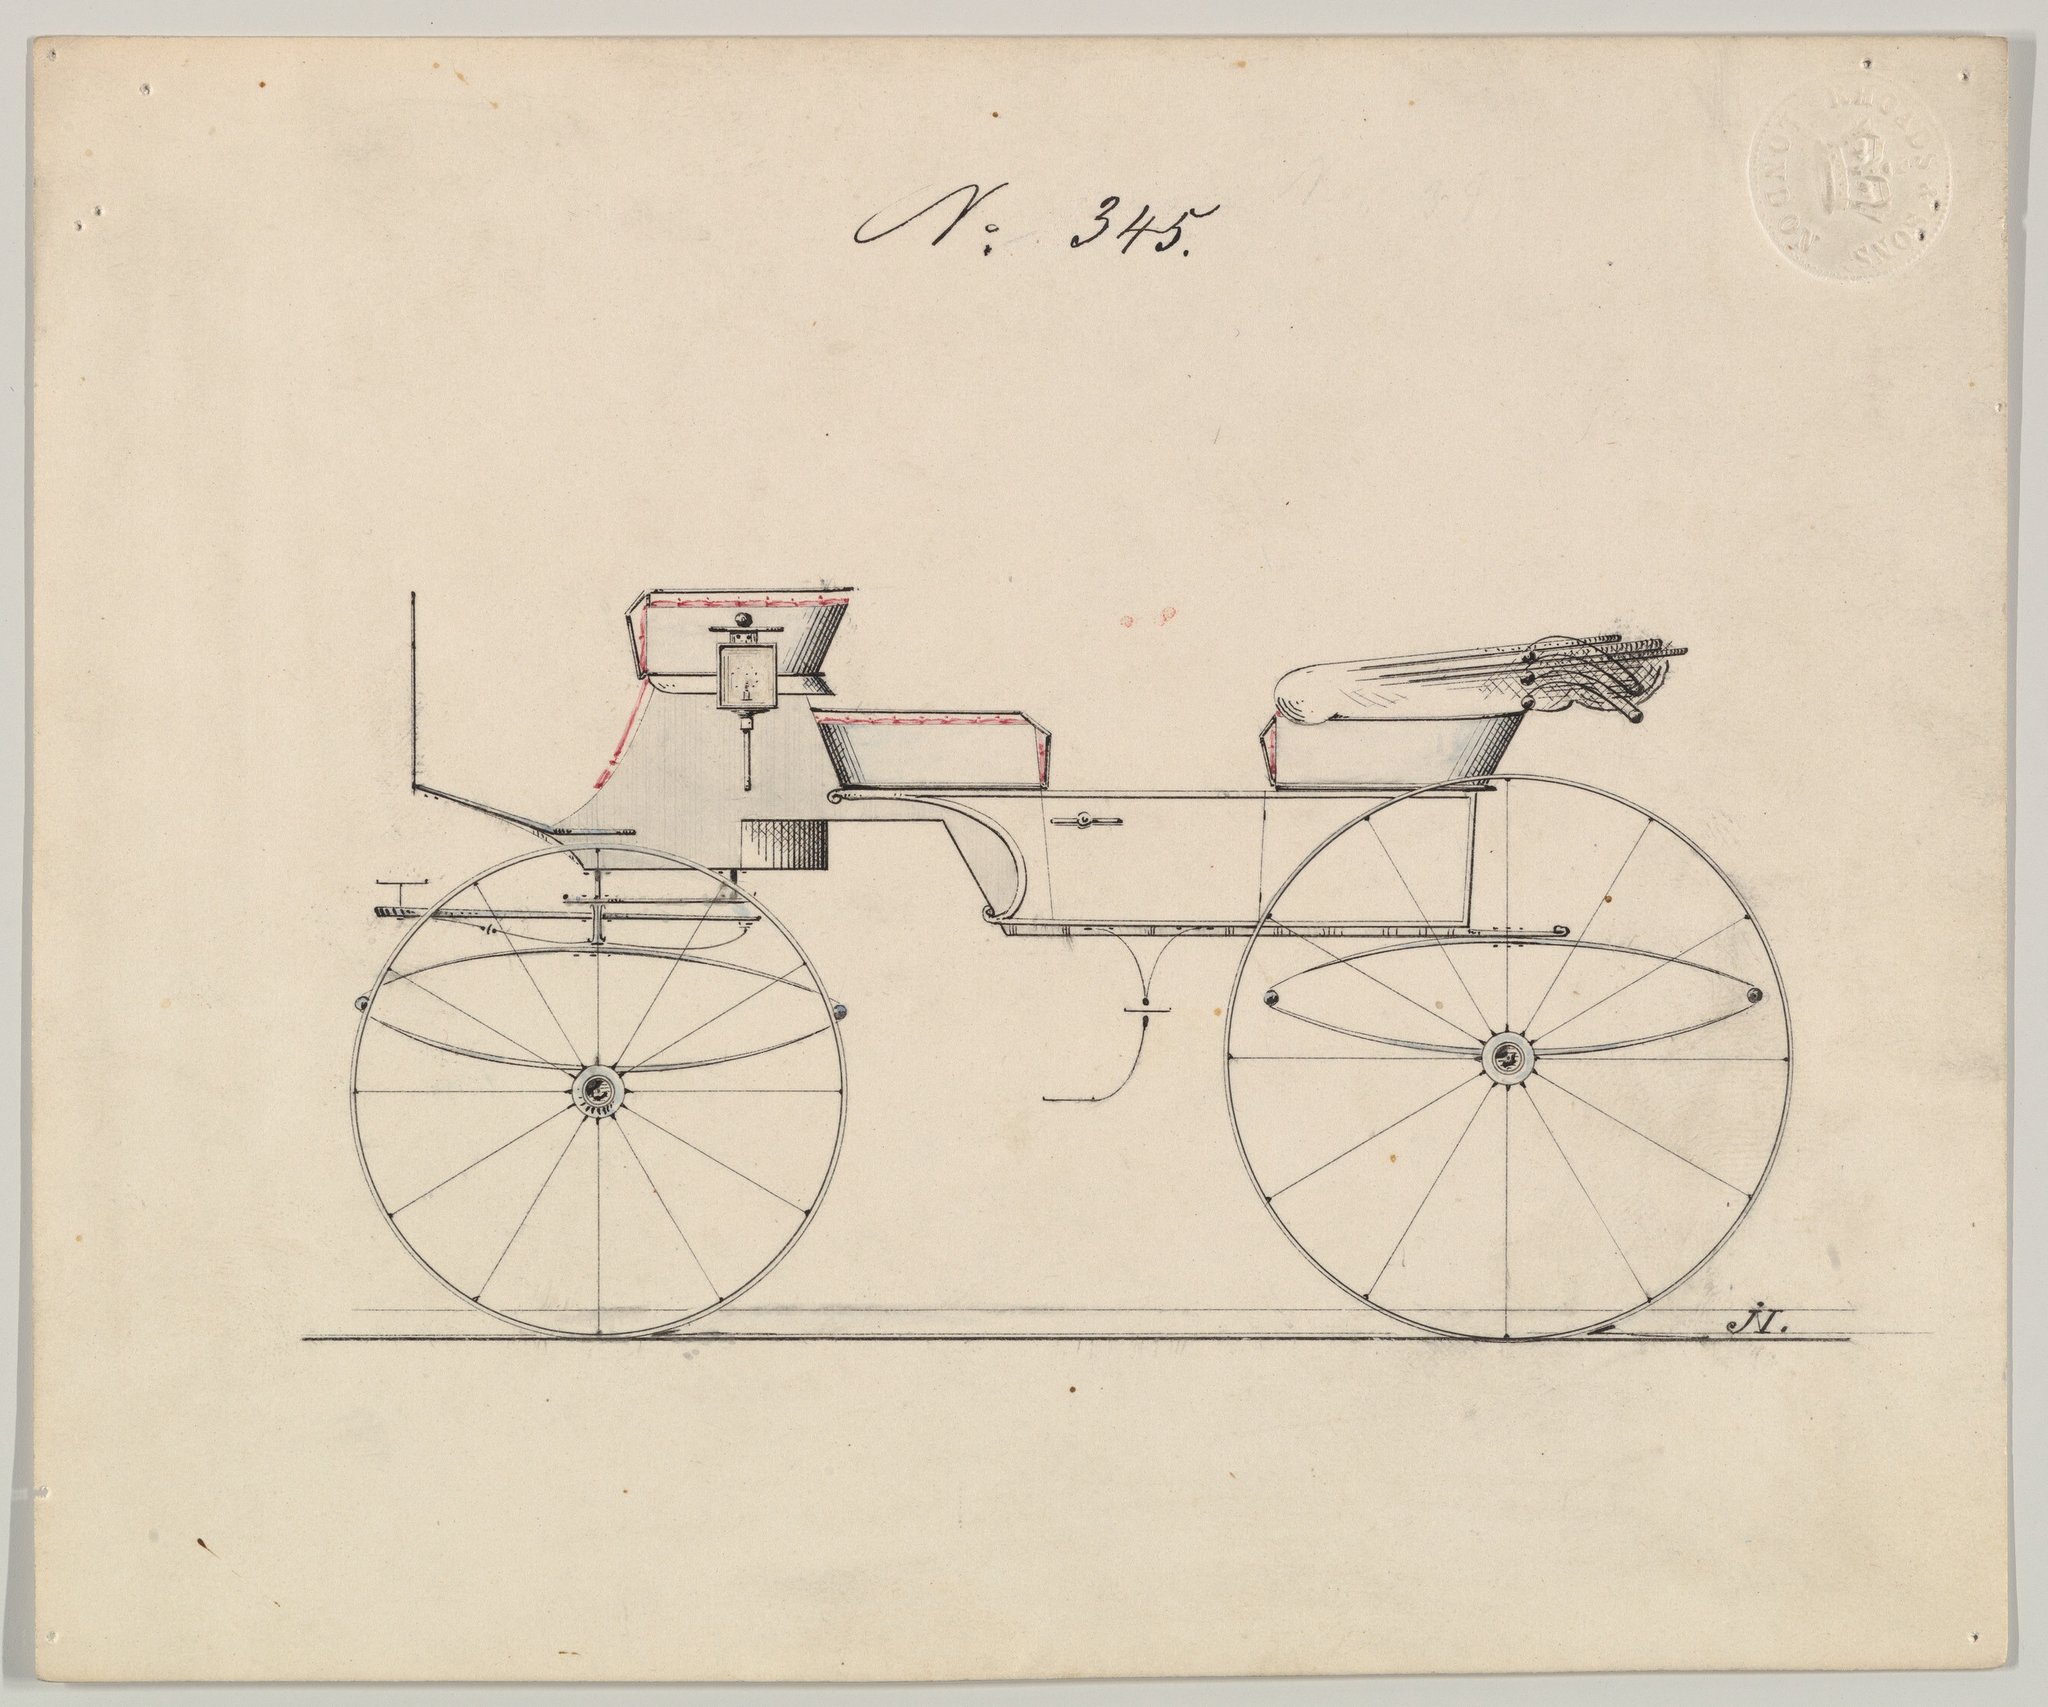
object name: drawing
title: Design for Vis-à-vis, no. 345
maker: brewster & co.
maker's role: manufacturer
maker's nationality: american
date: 1850-1870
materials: ink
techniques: pen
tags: carriages